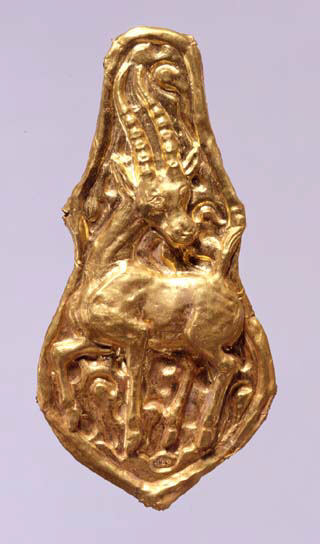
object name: harness ornament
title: Harness Ornament with Gazelle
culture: north chinese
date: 100 BCE-100 CE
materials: gold, iron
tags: deer